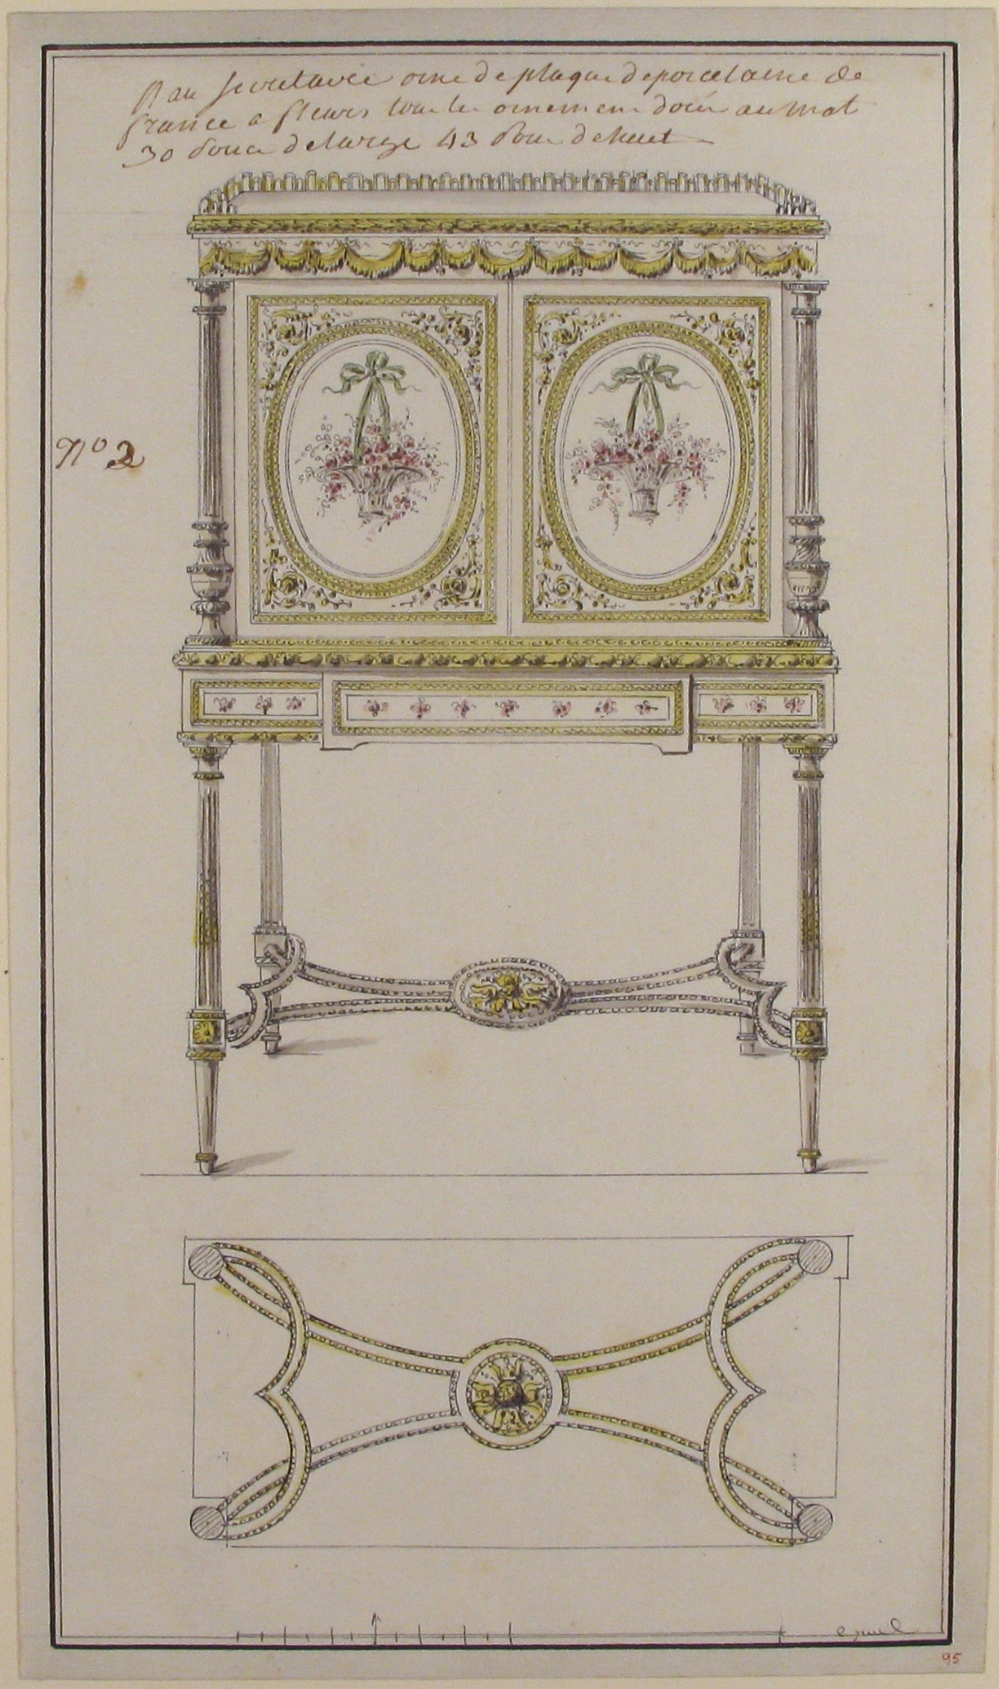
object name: drawing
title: Design for an Upright Drop-Front Secretary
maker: anonymous, french, 18th century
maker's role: artist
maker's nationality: french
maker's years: 1700-1800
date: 1780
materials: ink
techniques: brush, pen, wash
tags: furniture